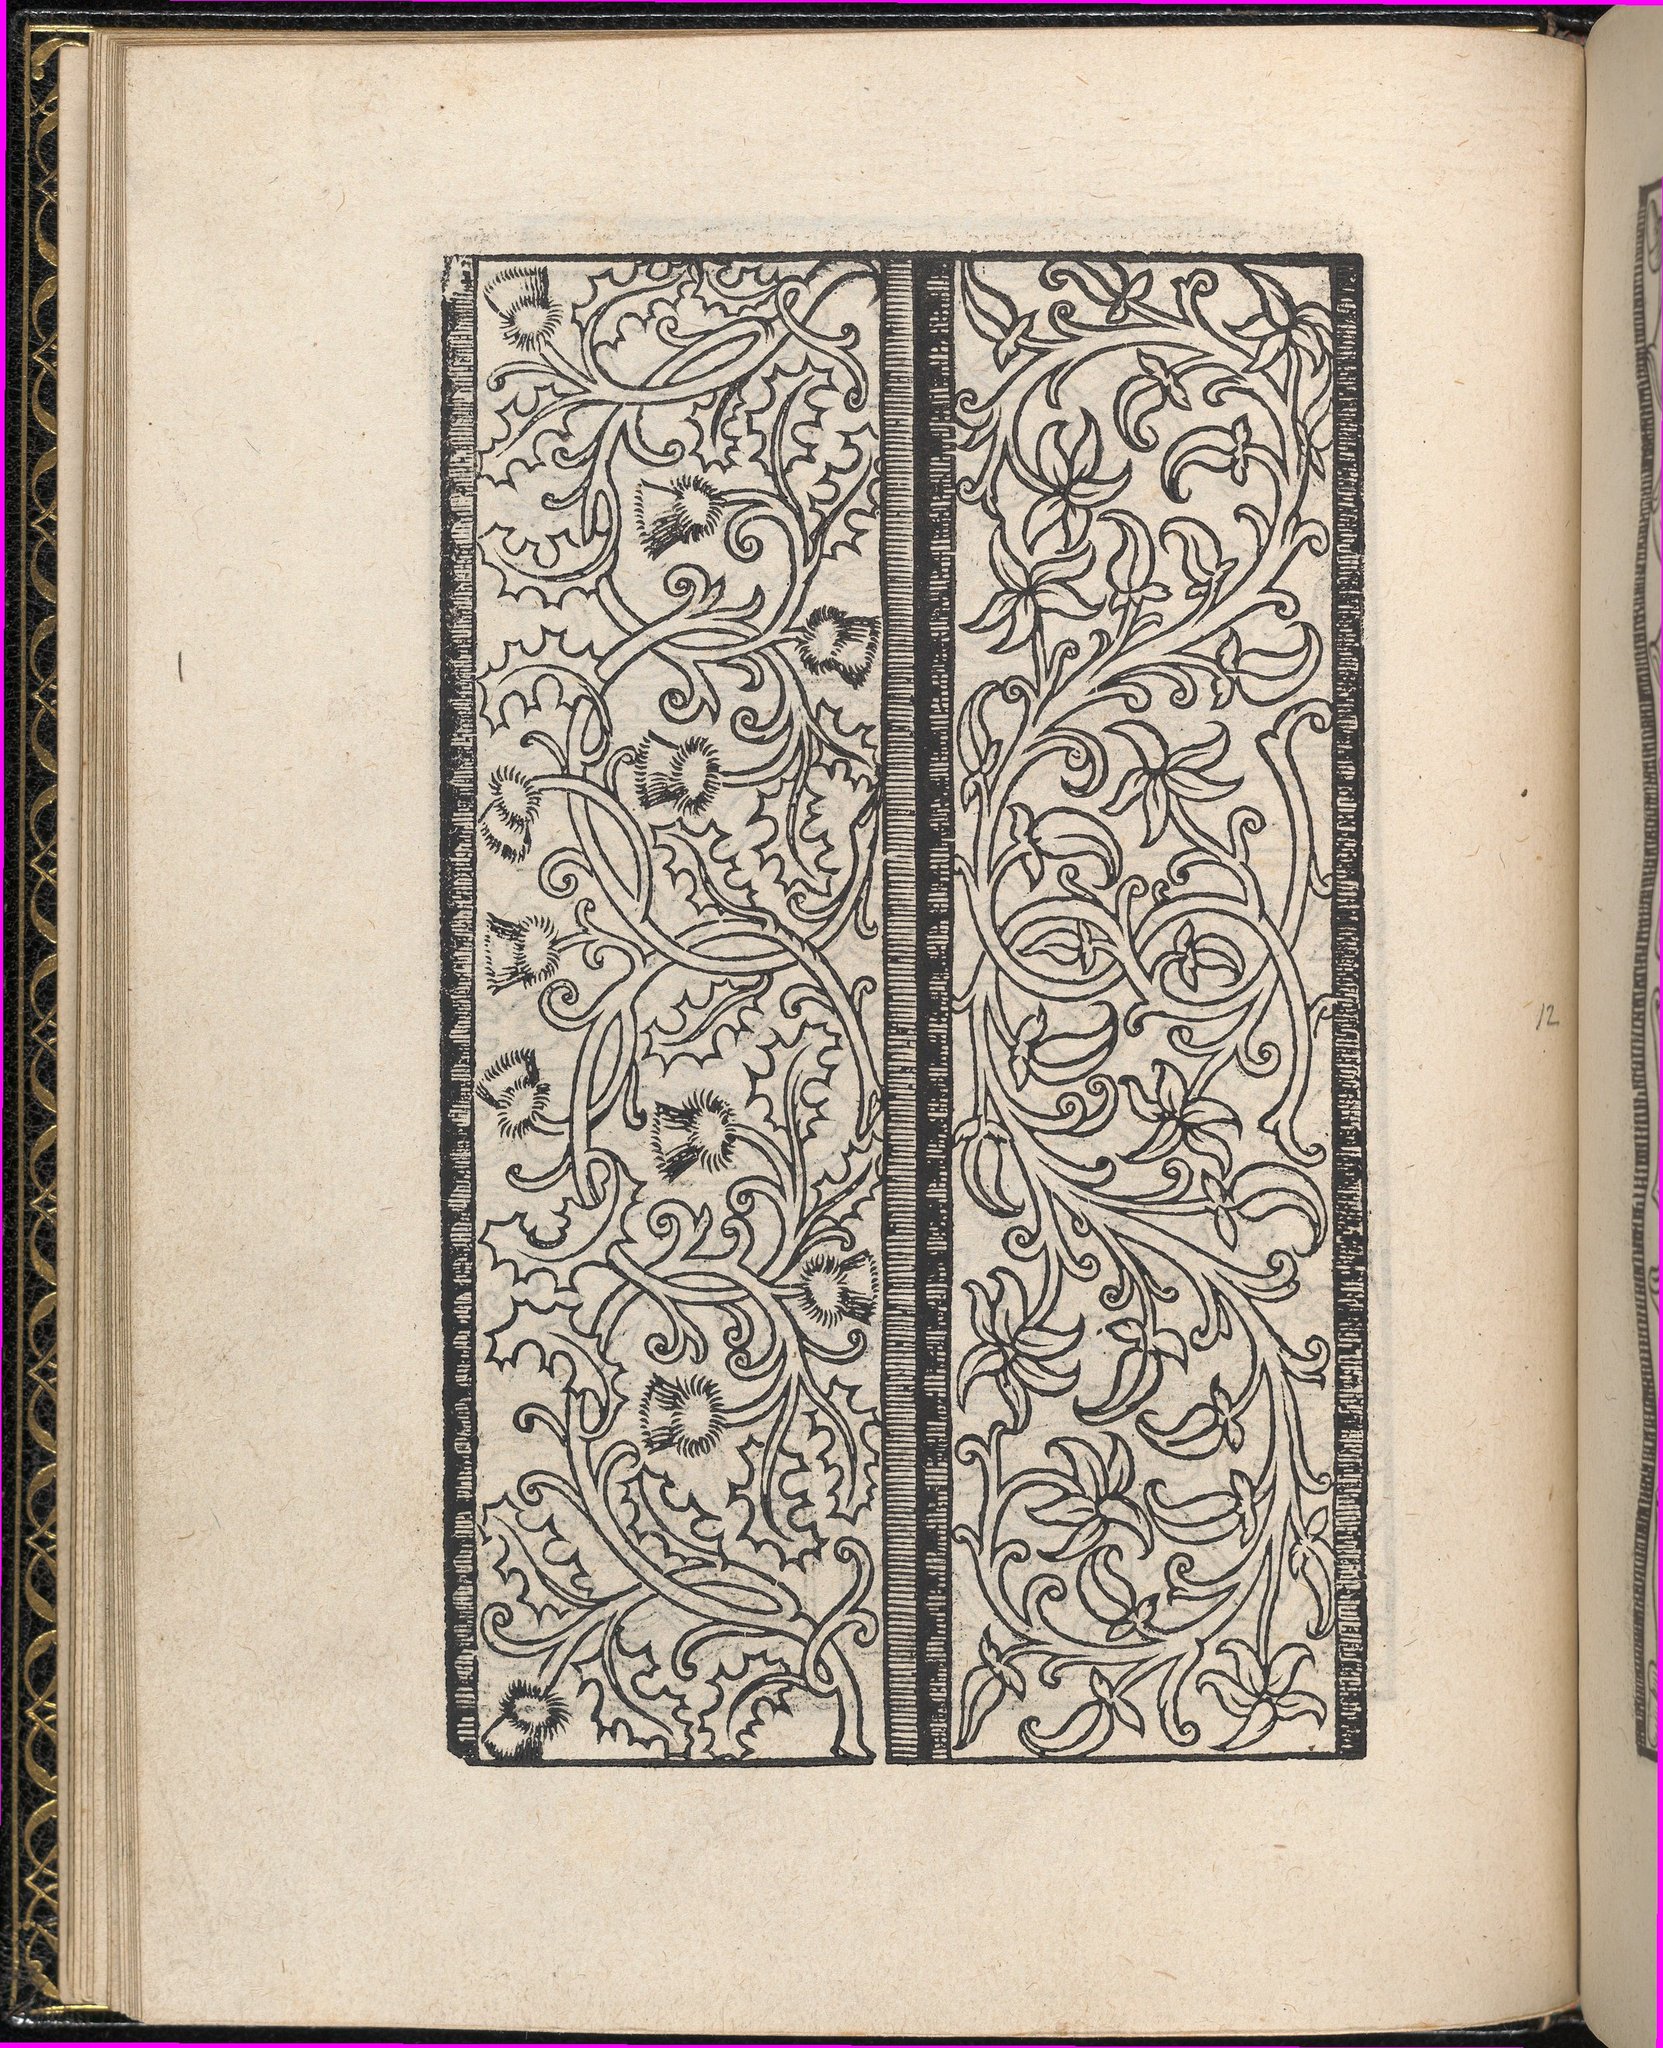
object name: book print ornament architecture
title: Page from Ein new kunstlich Modelbuch...(Page 12v)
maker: peter quentel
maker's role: publisher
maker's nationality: german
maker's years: 1500-1550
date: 1544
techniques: woodcut